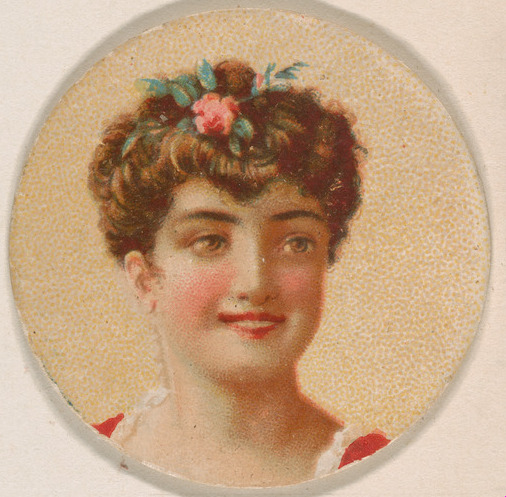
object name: print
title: Portrait of woman, from the Novelties series (N228, Type 1) issued by Kinney Bros.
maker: kinney brothers tobacco company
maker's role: publisher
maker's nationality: american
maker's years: 1869-2011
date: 1889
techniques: color lithograph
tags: portraits,women